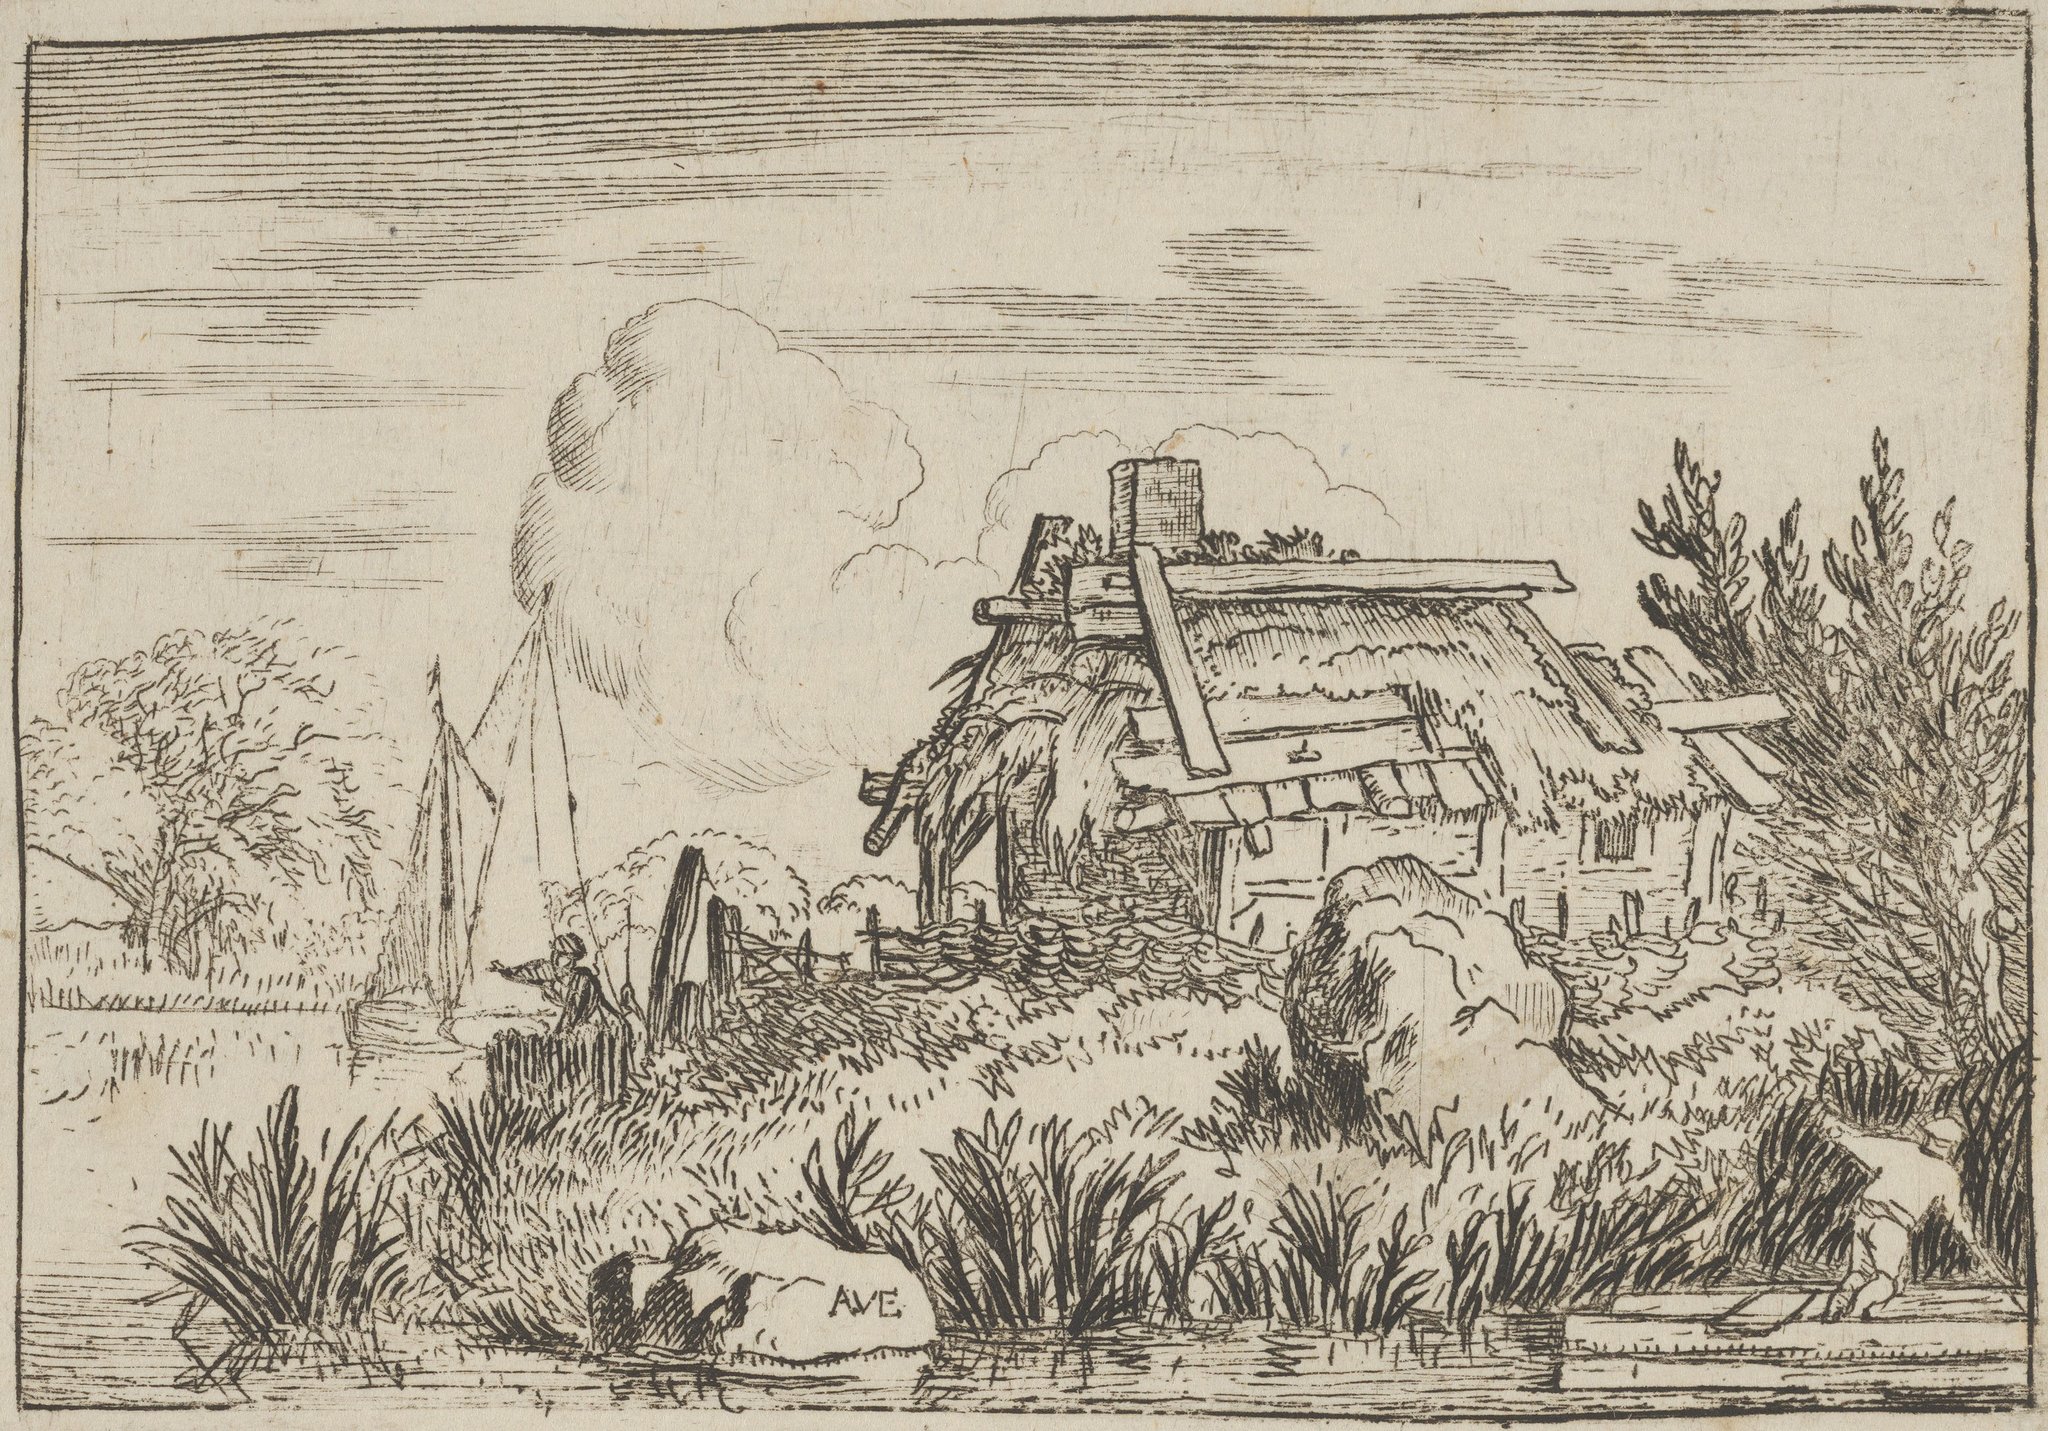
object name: print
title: The Ruined Cottage, Surrounded by Water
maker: allart van everdingen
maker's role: artist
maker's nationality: dutch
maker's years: 1621-1675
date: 1621-1675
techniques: engraving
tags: houses,ruins